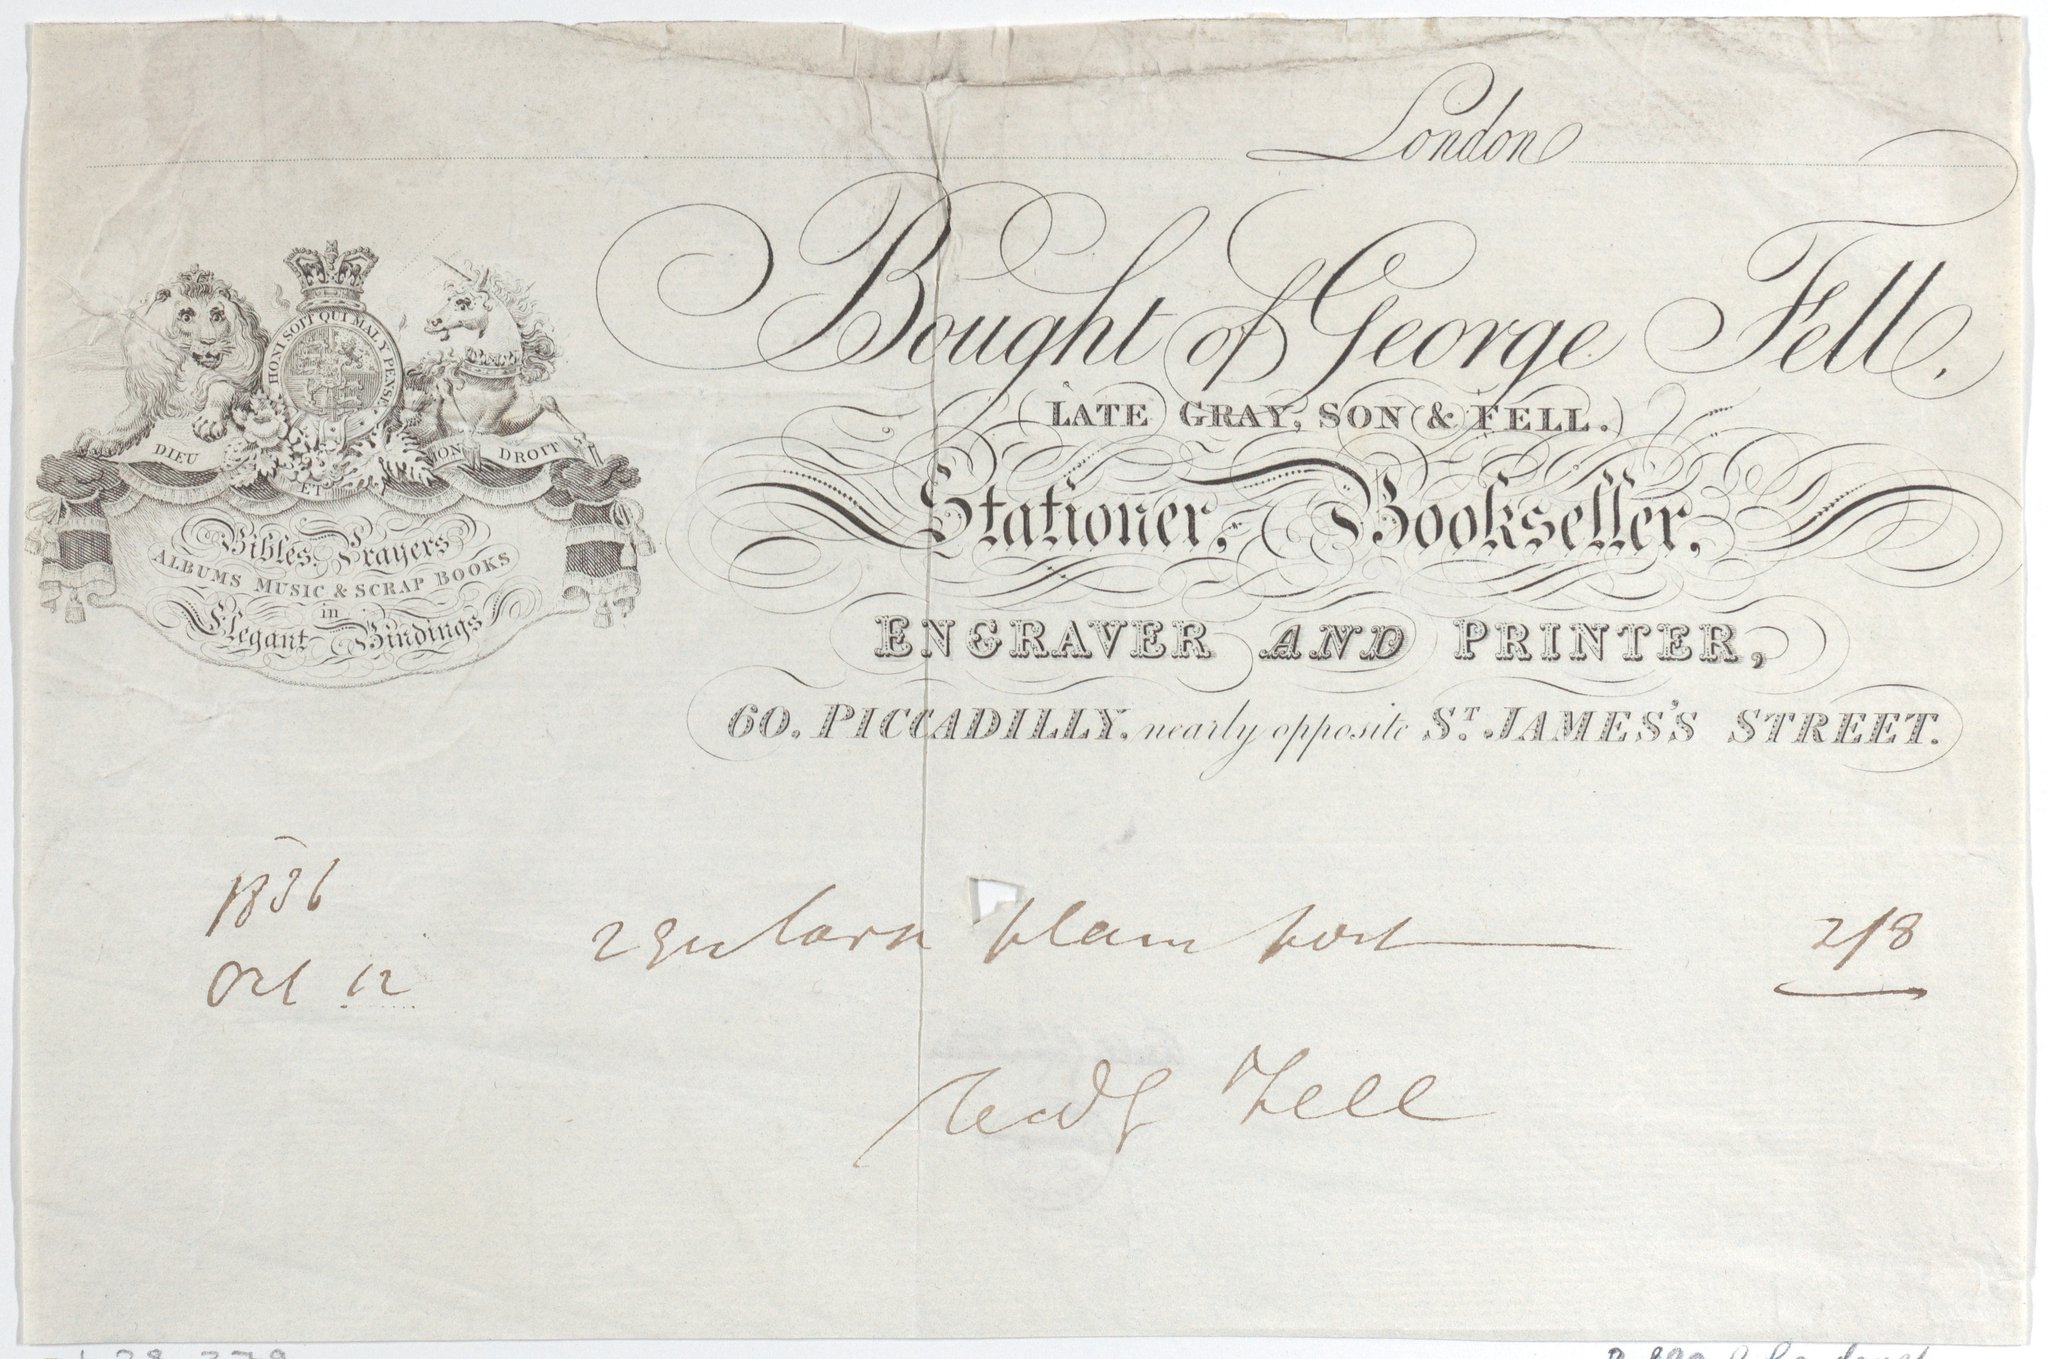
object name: print, trade card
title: Trade Card for George Fell, Stationer, Bookseller, Engraver and Printer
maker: anonymous, british, 19th century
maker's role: artist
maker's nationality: british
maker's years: 1800-1900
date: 1801-1900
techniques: engraving